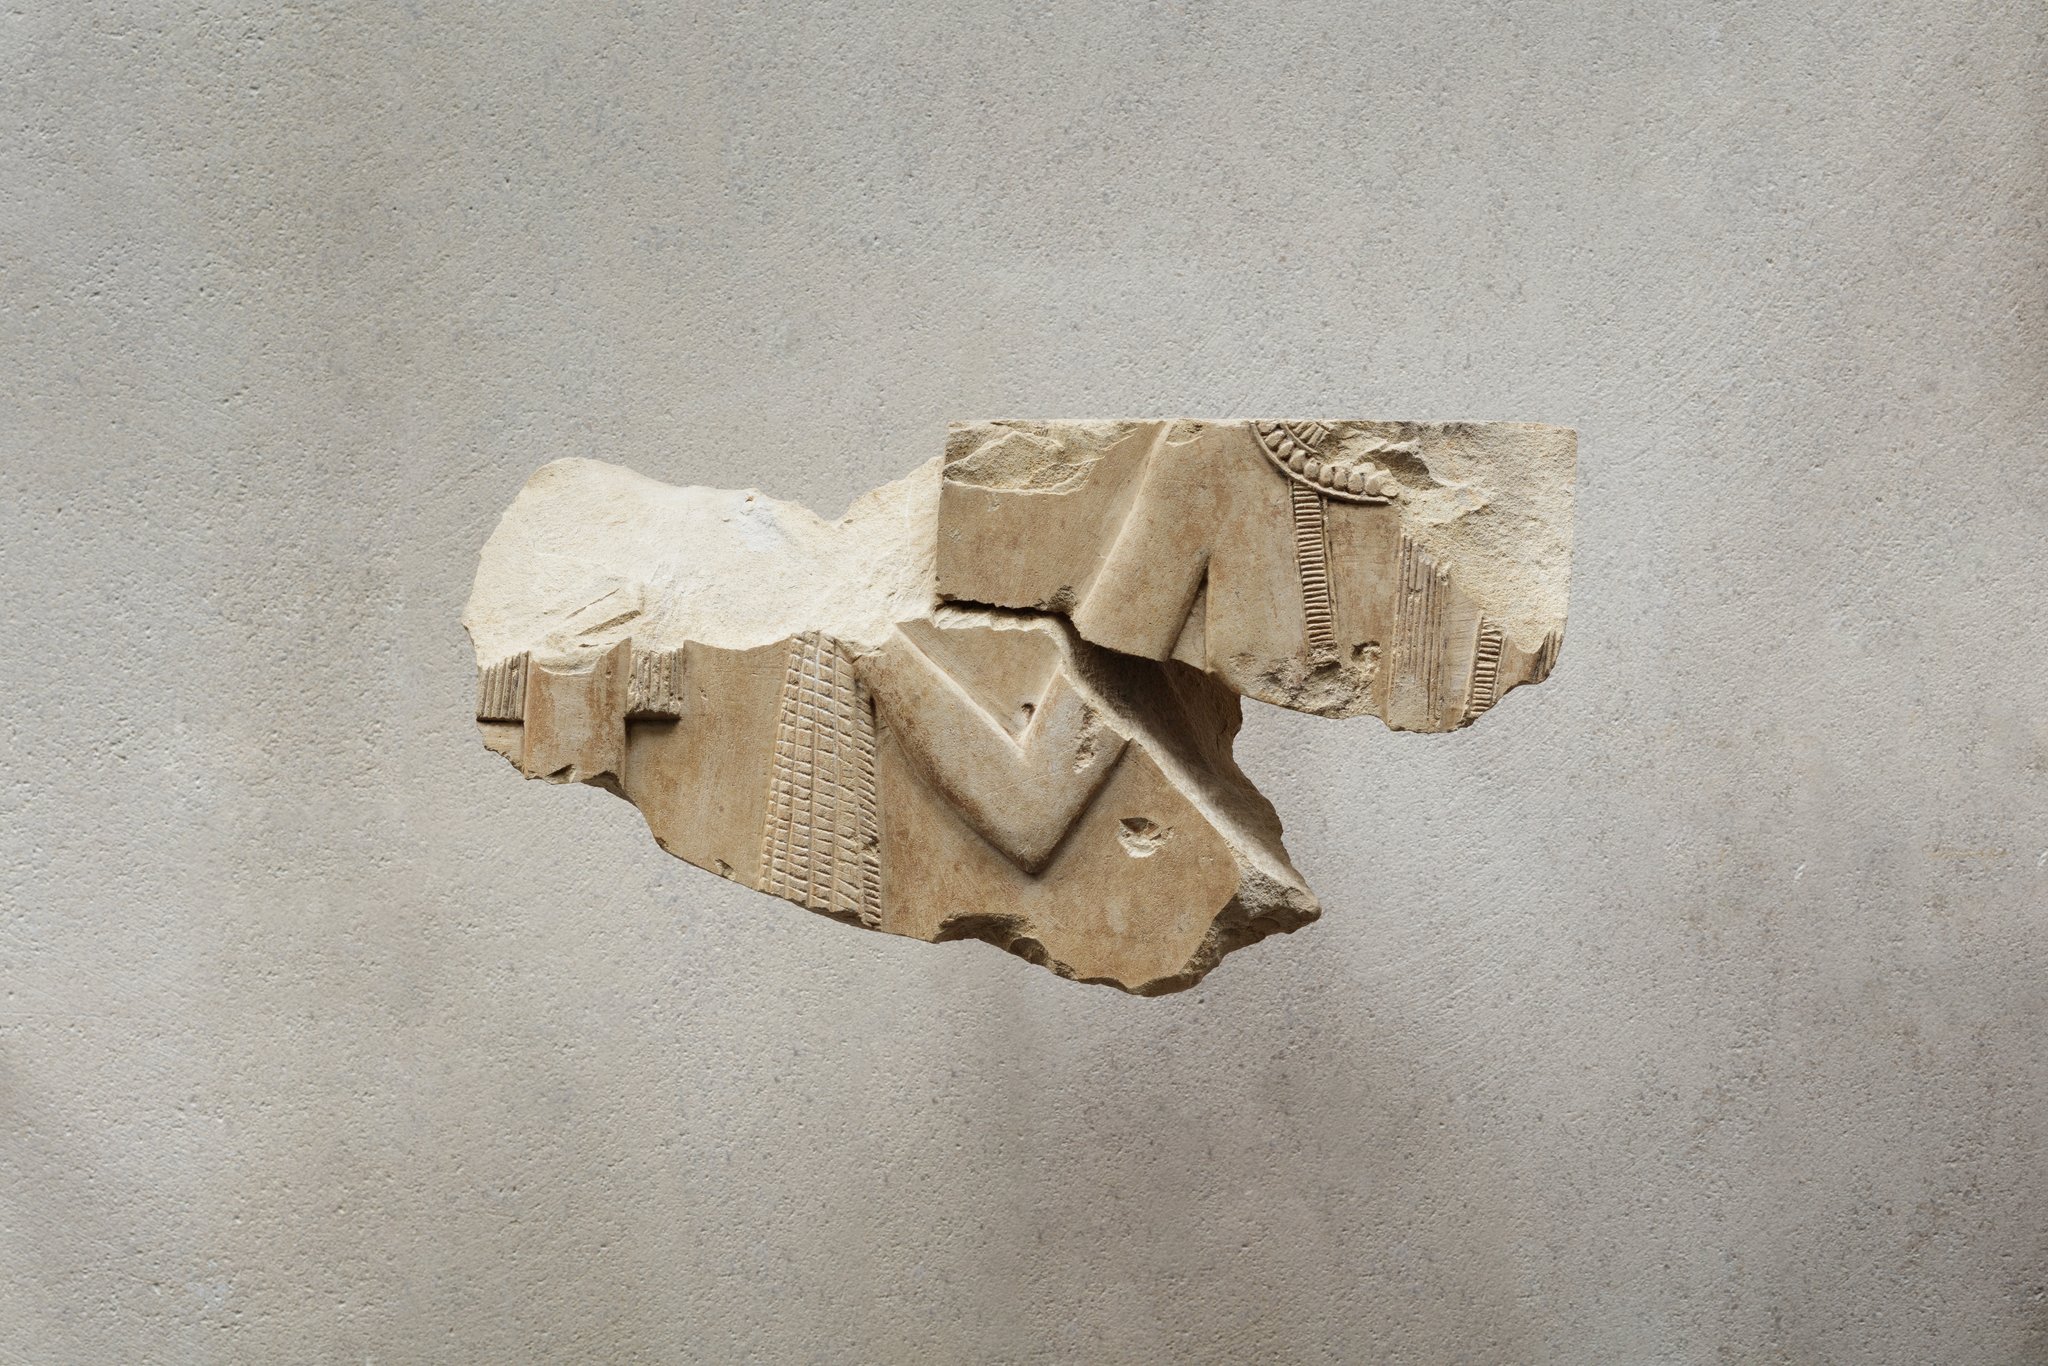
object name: relief fragment, tomb of neferu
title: Relief of an attendant raising a necklace in front of a pole-like image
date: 2051-2030 BCE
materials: limestone, paint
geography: egypt